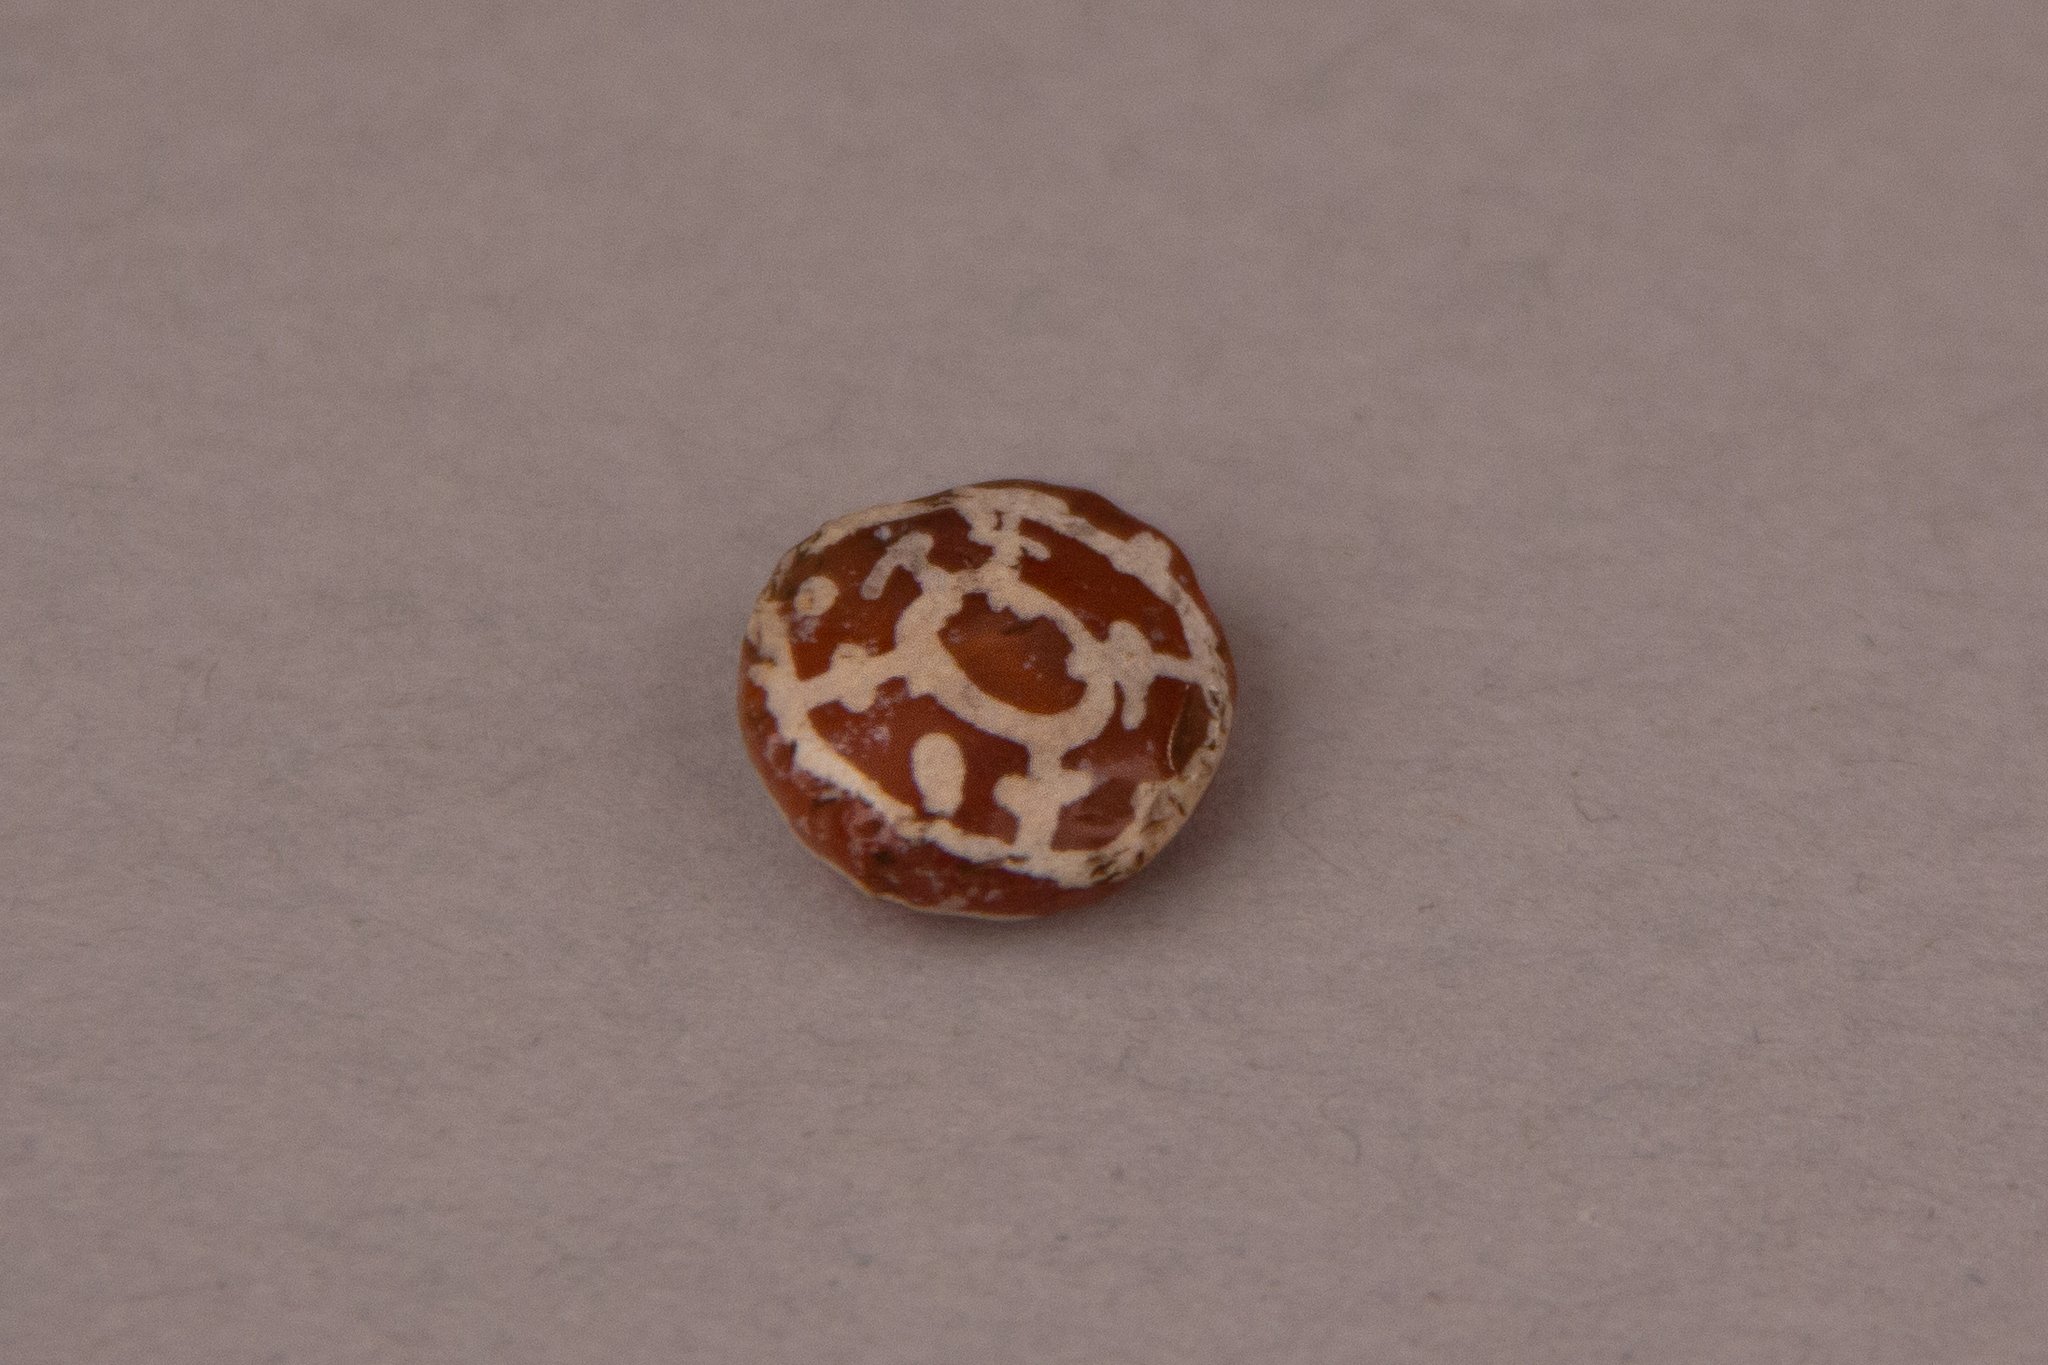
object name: bead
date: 801-1900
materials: gemstone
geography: egypt